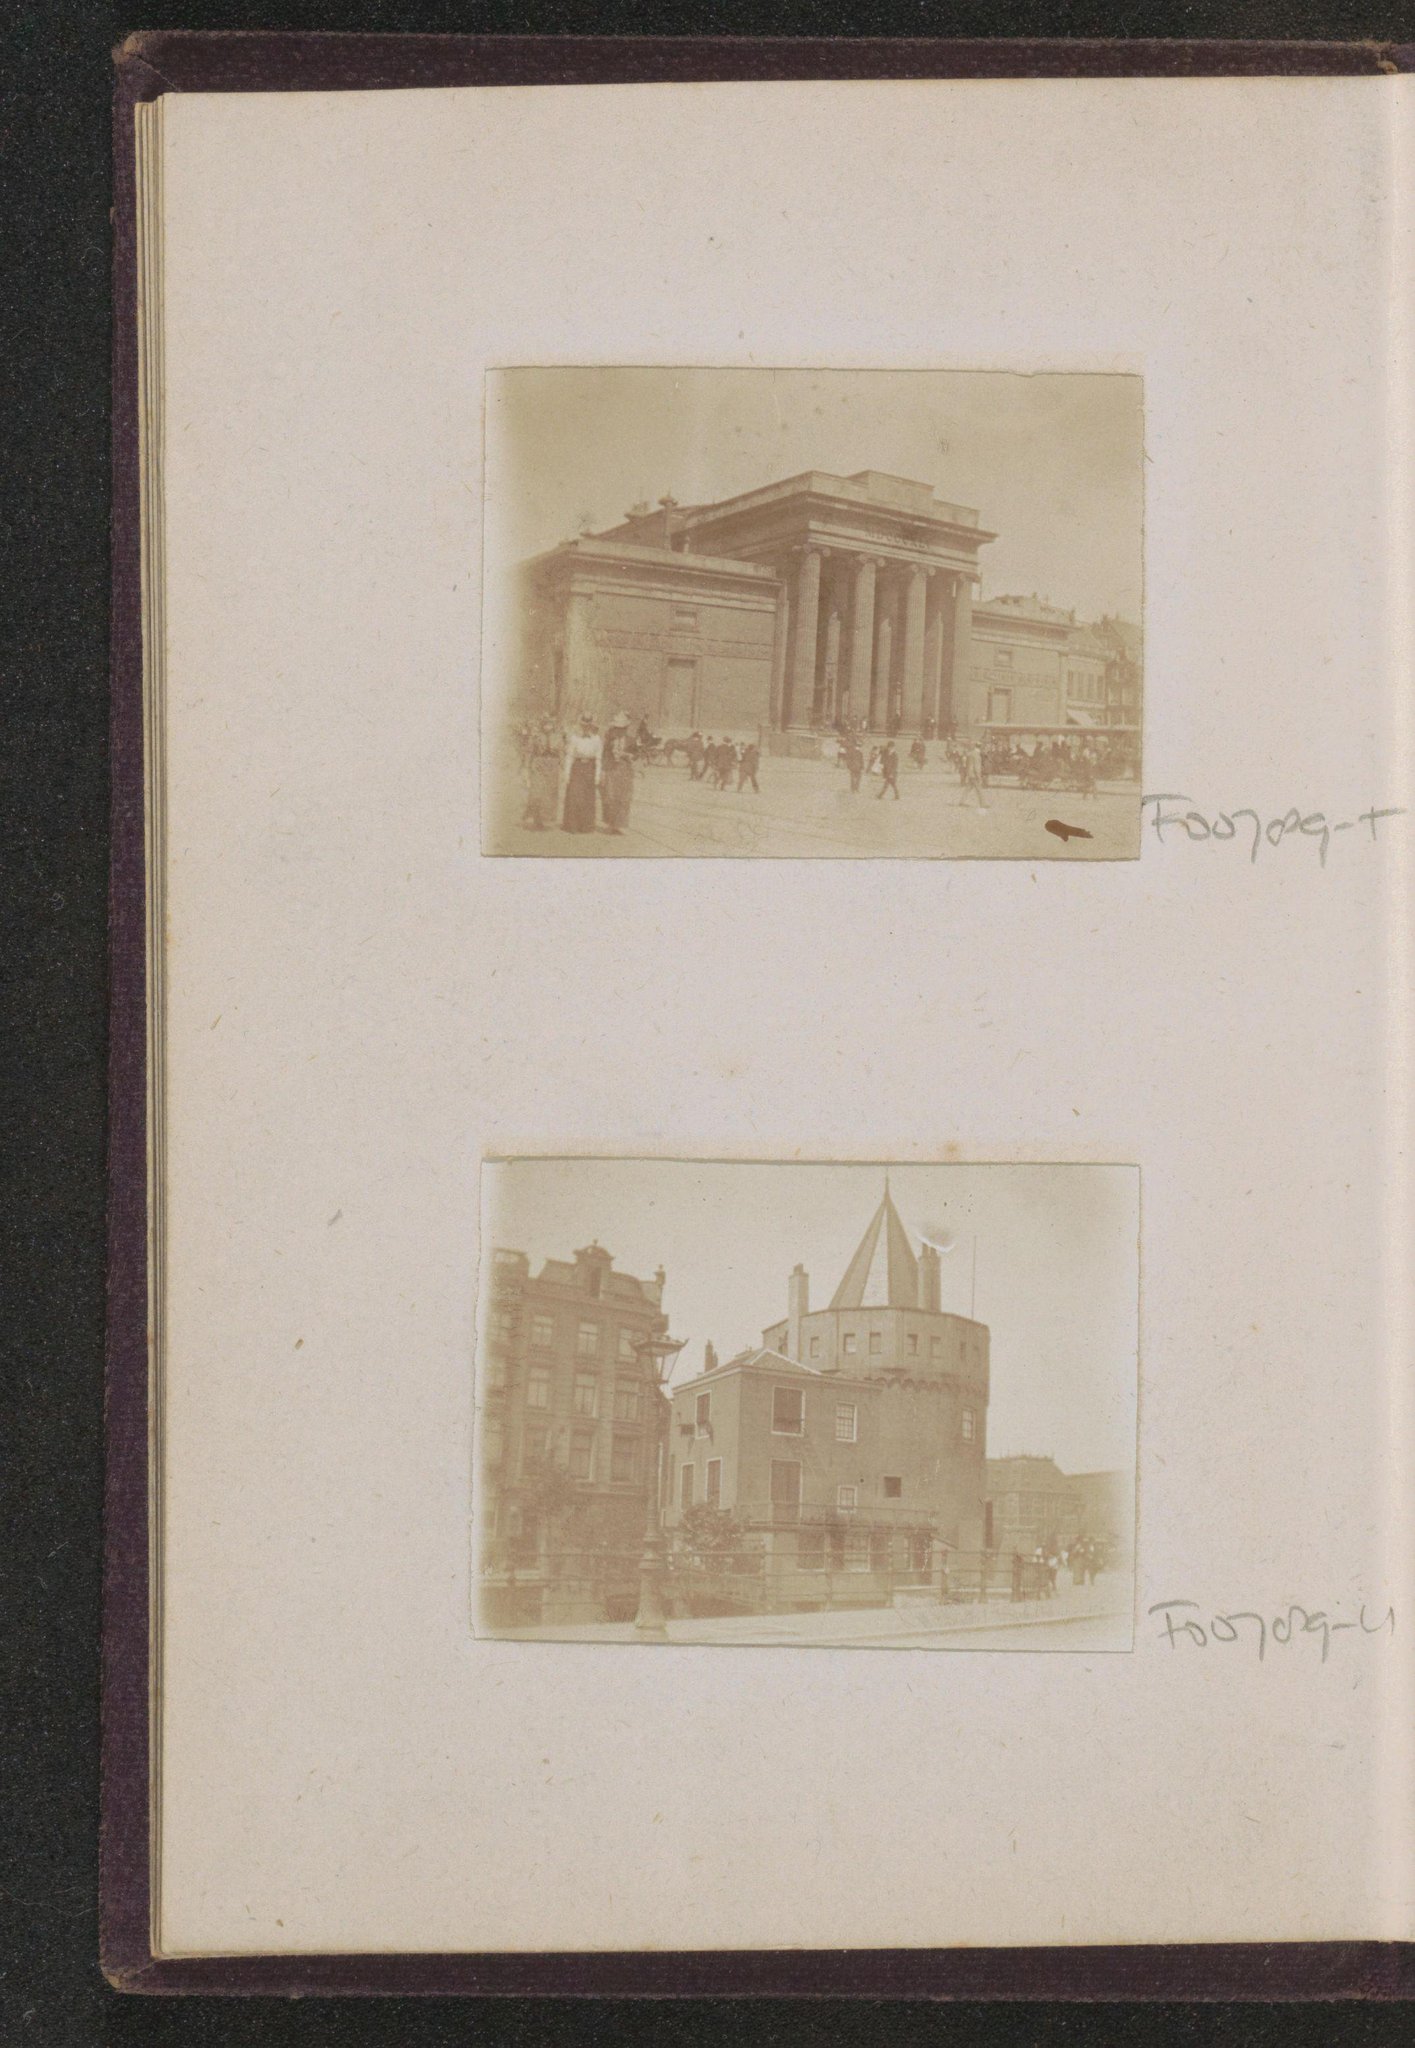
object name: photograph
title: Schreierstoren gezien vanaf de Geldersekade in Amsterdam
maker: Anonymous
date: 1890-1903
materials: paper, photographic support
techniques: collodion silver print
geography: amsterdam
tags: towers ~ fortified city, amsterdam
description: Onderdeel van Fotoalbum met 35 foto's van Amsterdam, personen en dieren.